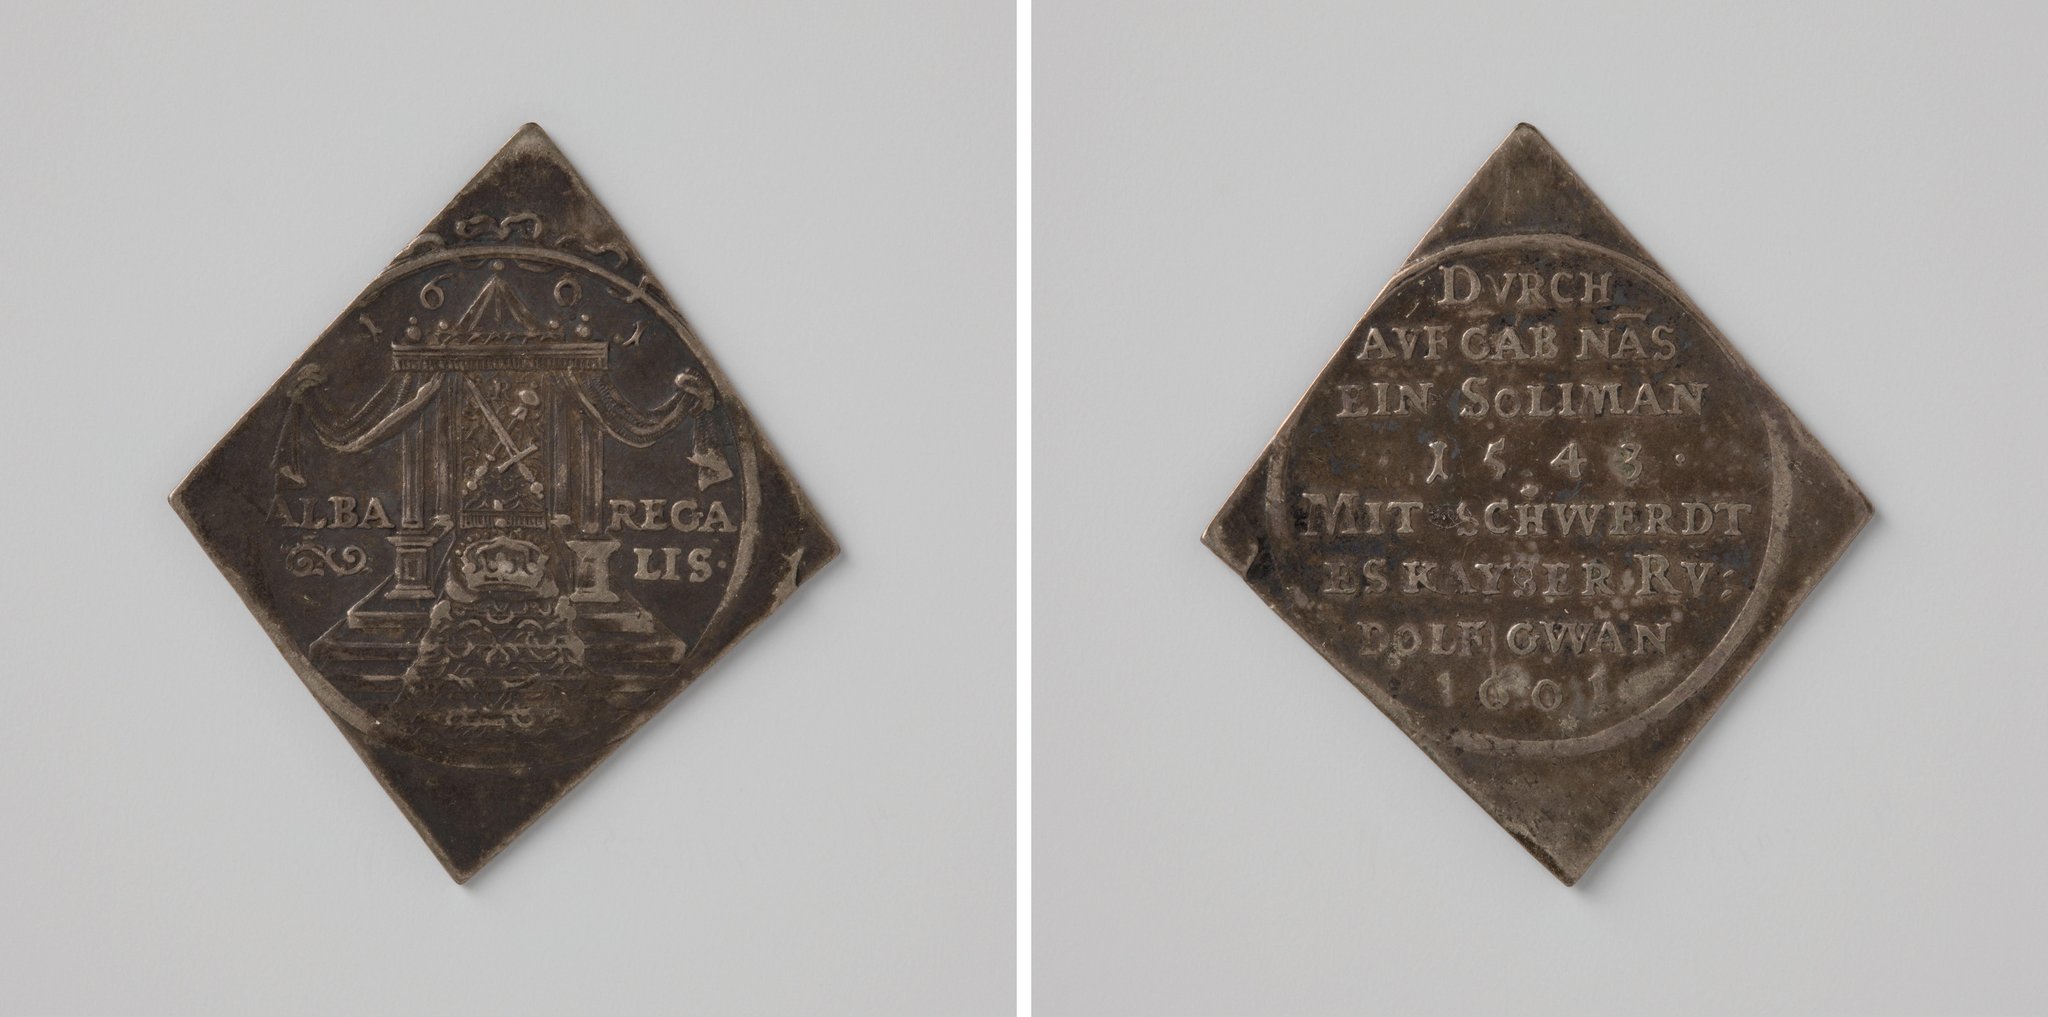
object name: history medal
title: Inname van Stuhl-Weissenbruck door keizer Rudolf II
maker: Anonymous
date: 1601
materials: silver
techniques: striking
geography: germany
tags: vienna, prague, rudolf ii van habsburg (duits keizer)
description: Zilveren ruitvormige penning. Voorzijde: wapenschild (gekruist zwaard en scepter) en kroon onder baldakijn met trap er voor. Keerzijde: inscriptie